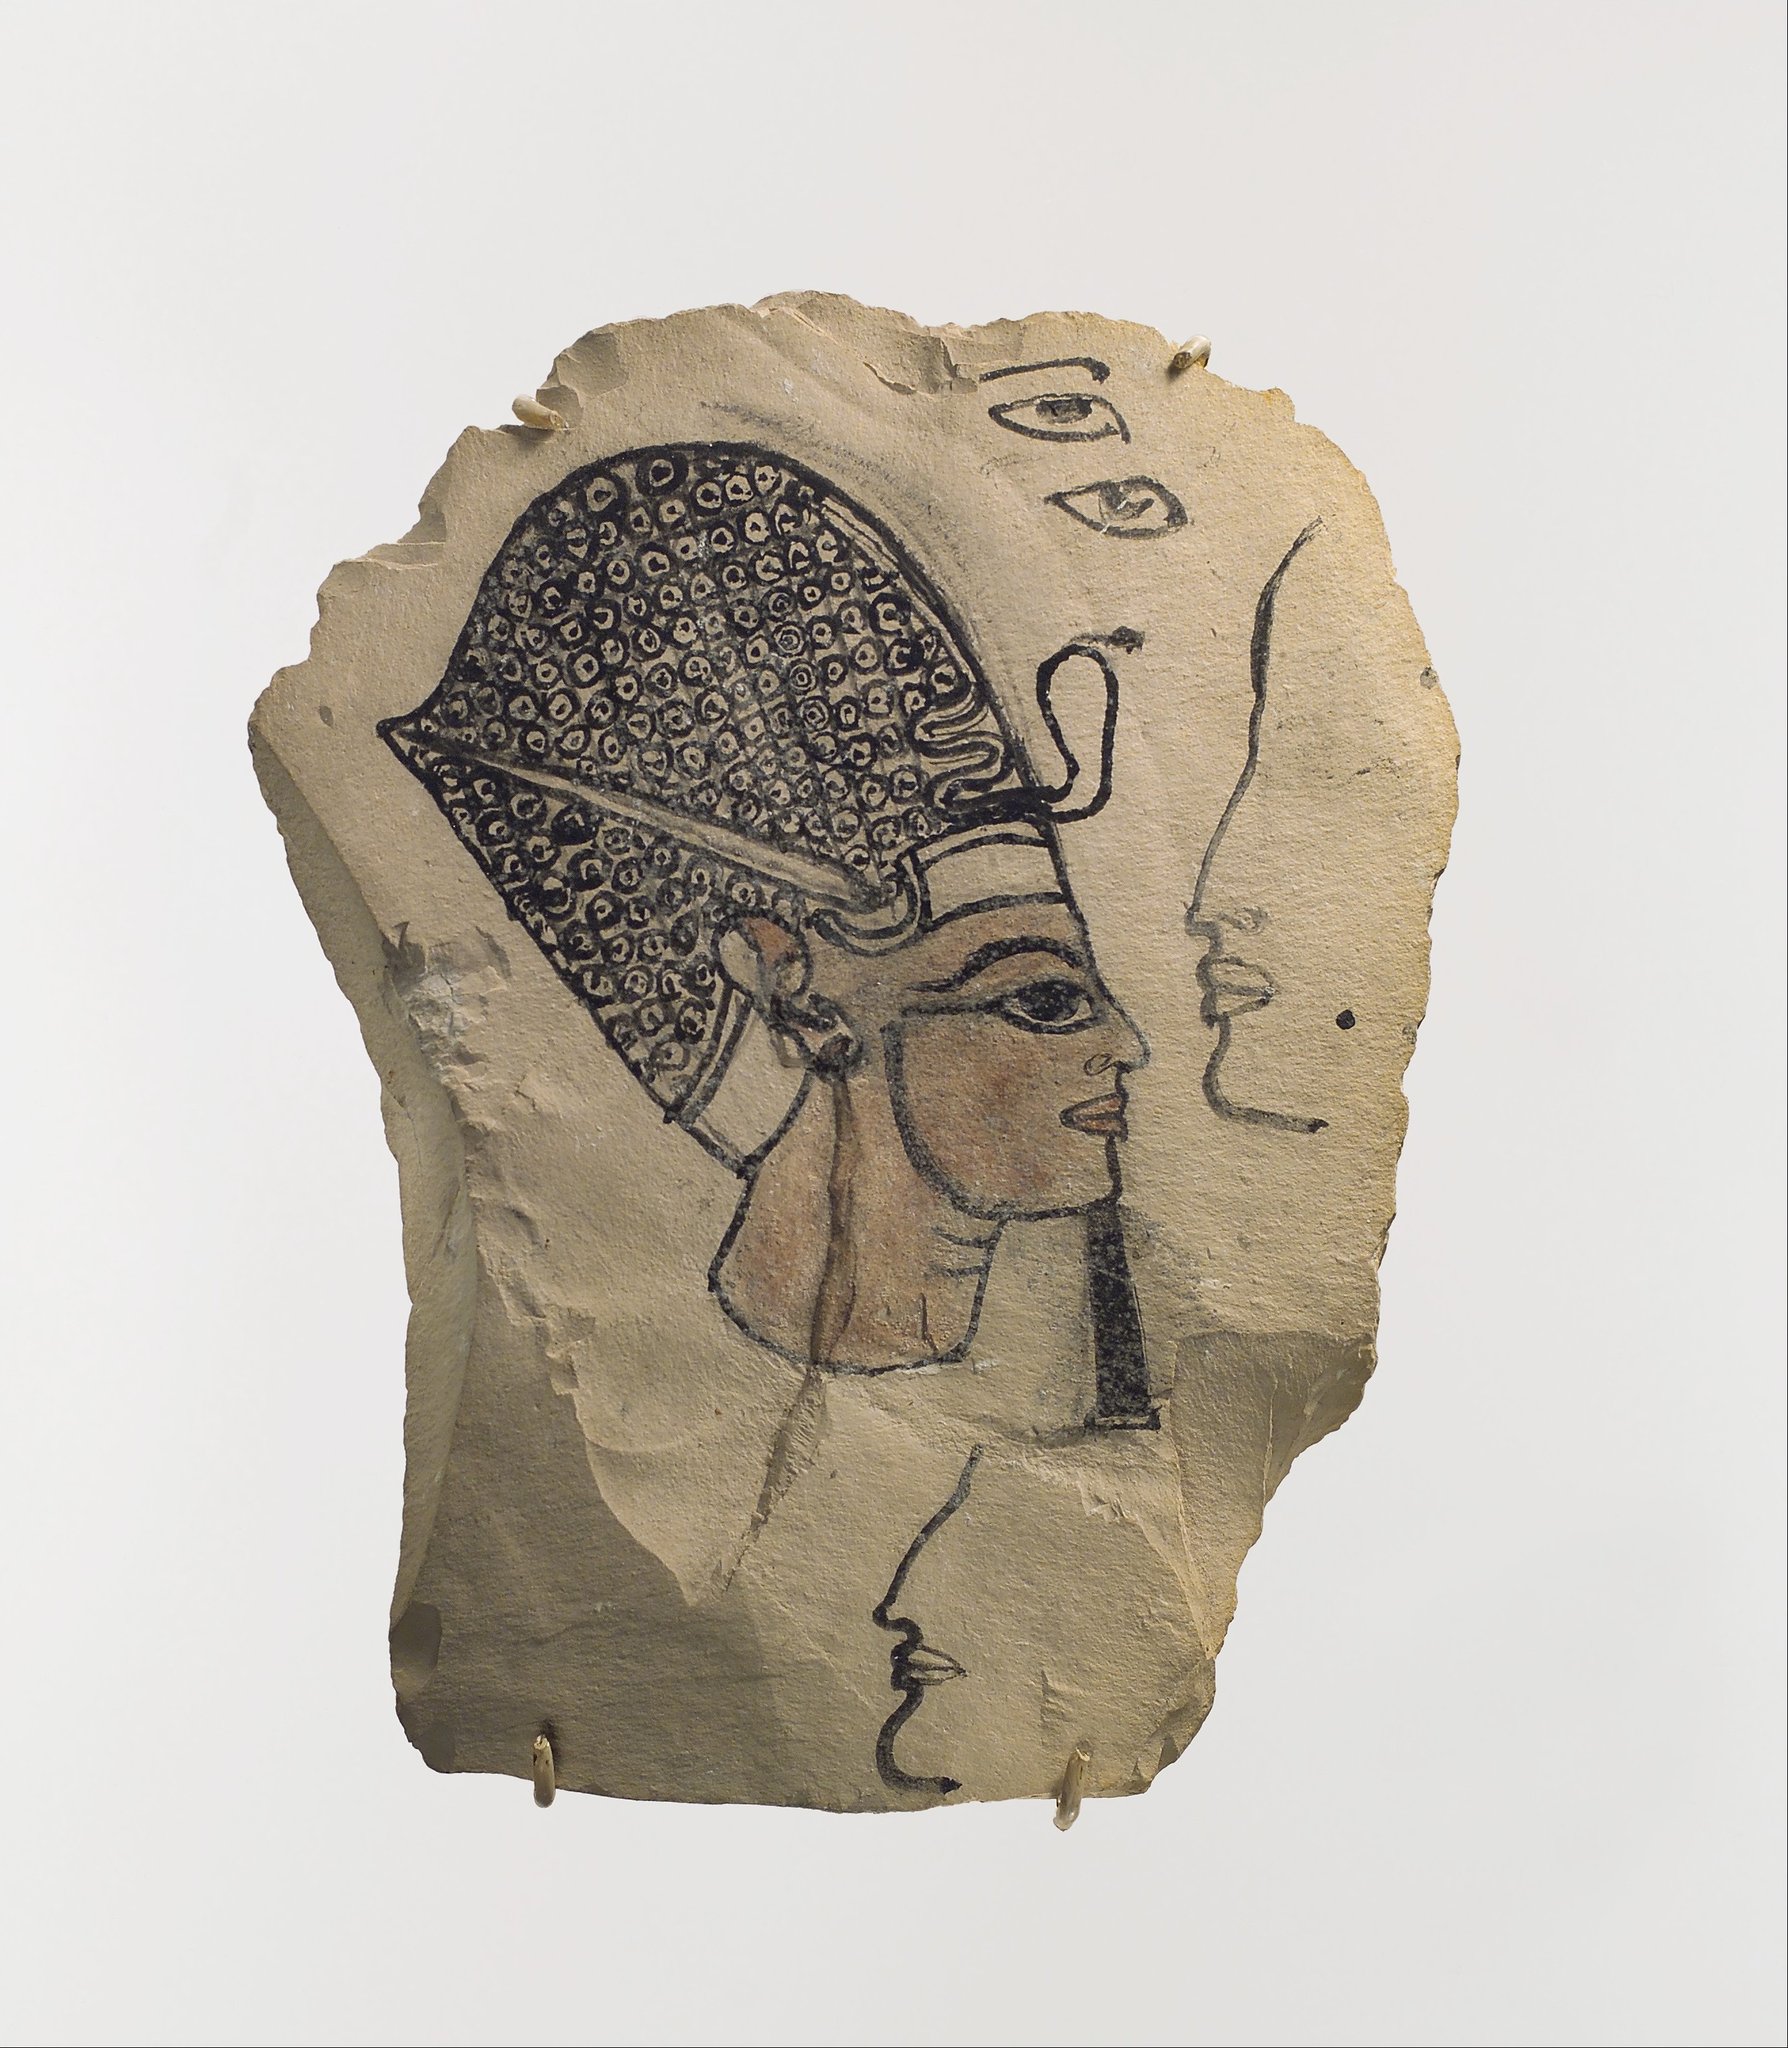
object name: ostracon, figured, ramesses iv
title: Artist's Sketch of Ramesses IV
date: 1153-1147 BCE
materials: ink, limestone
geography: egypt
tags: kings,men